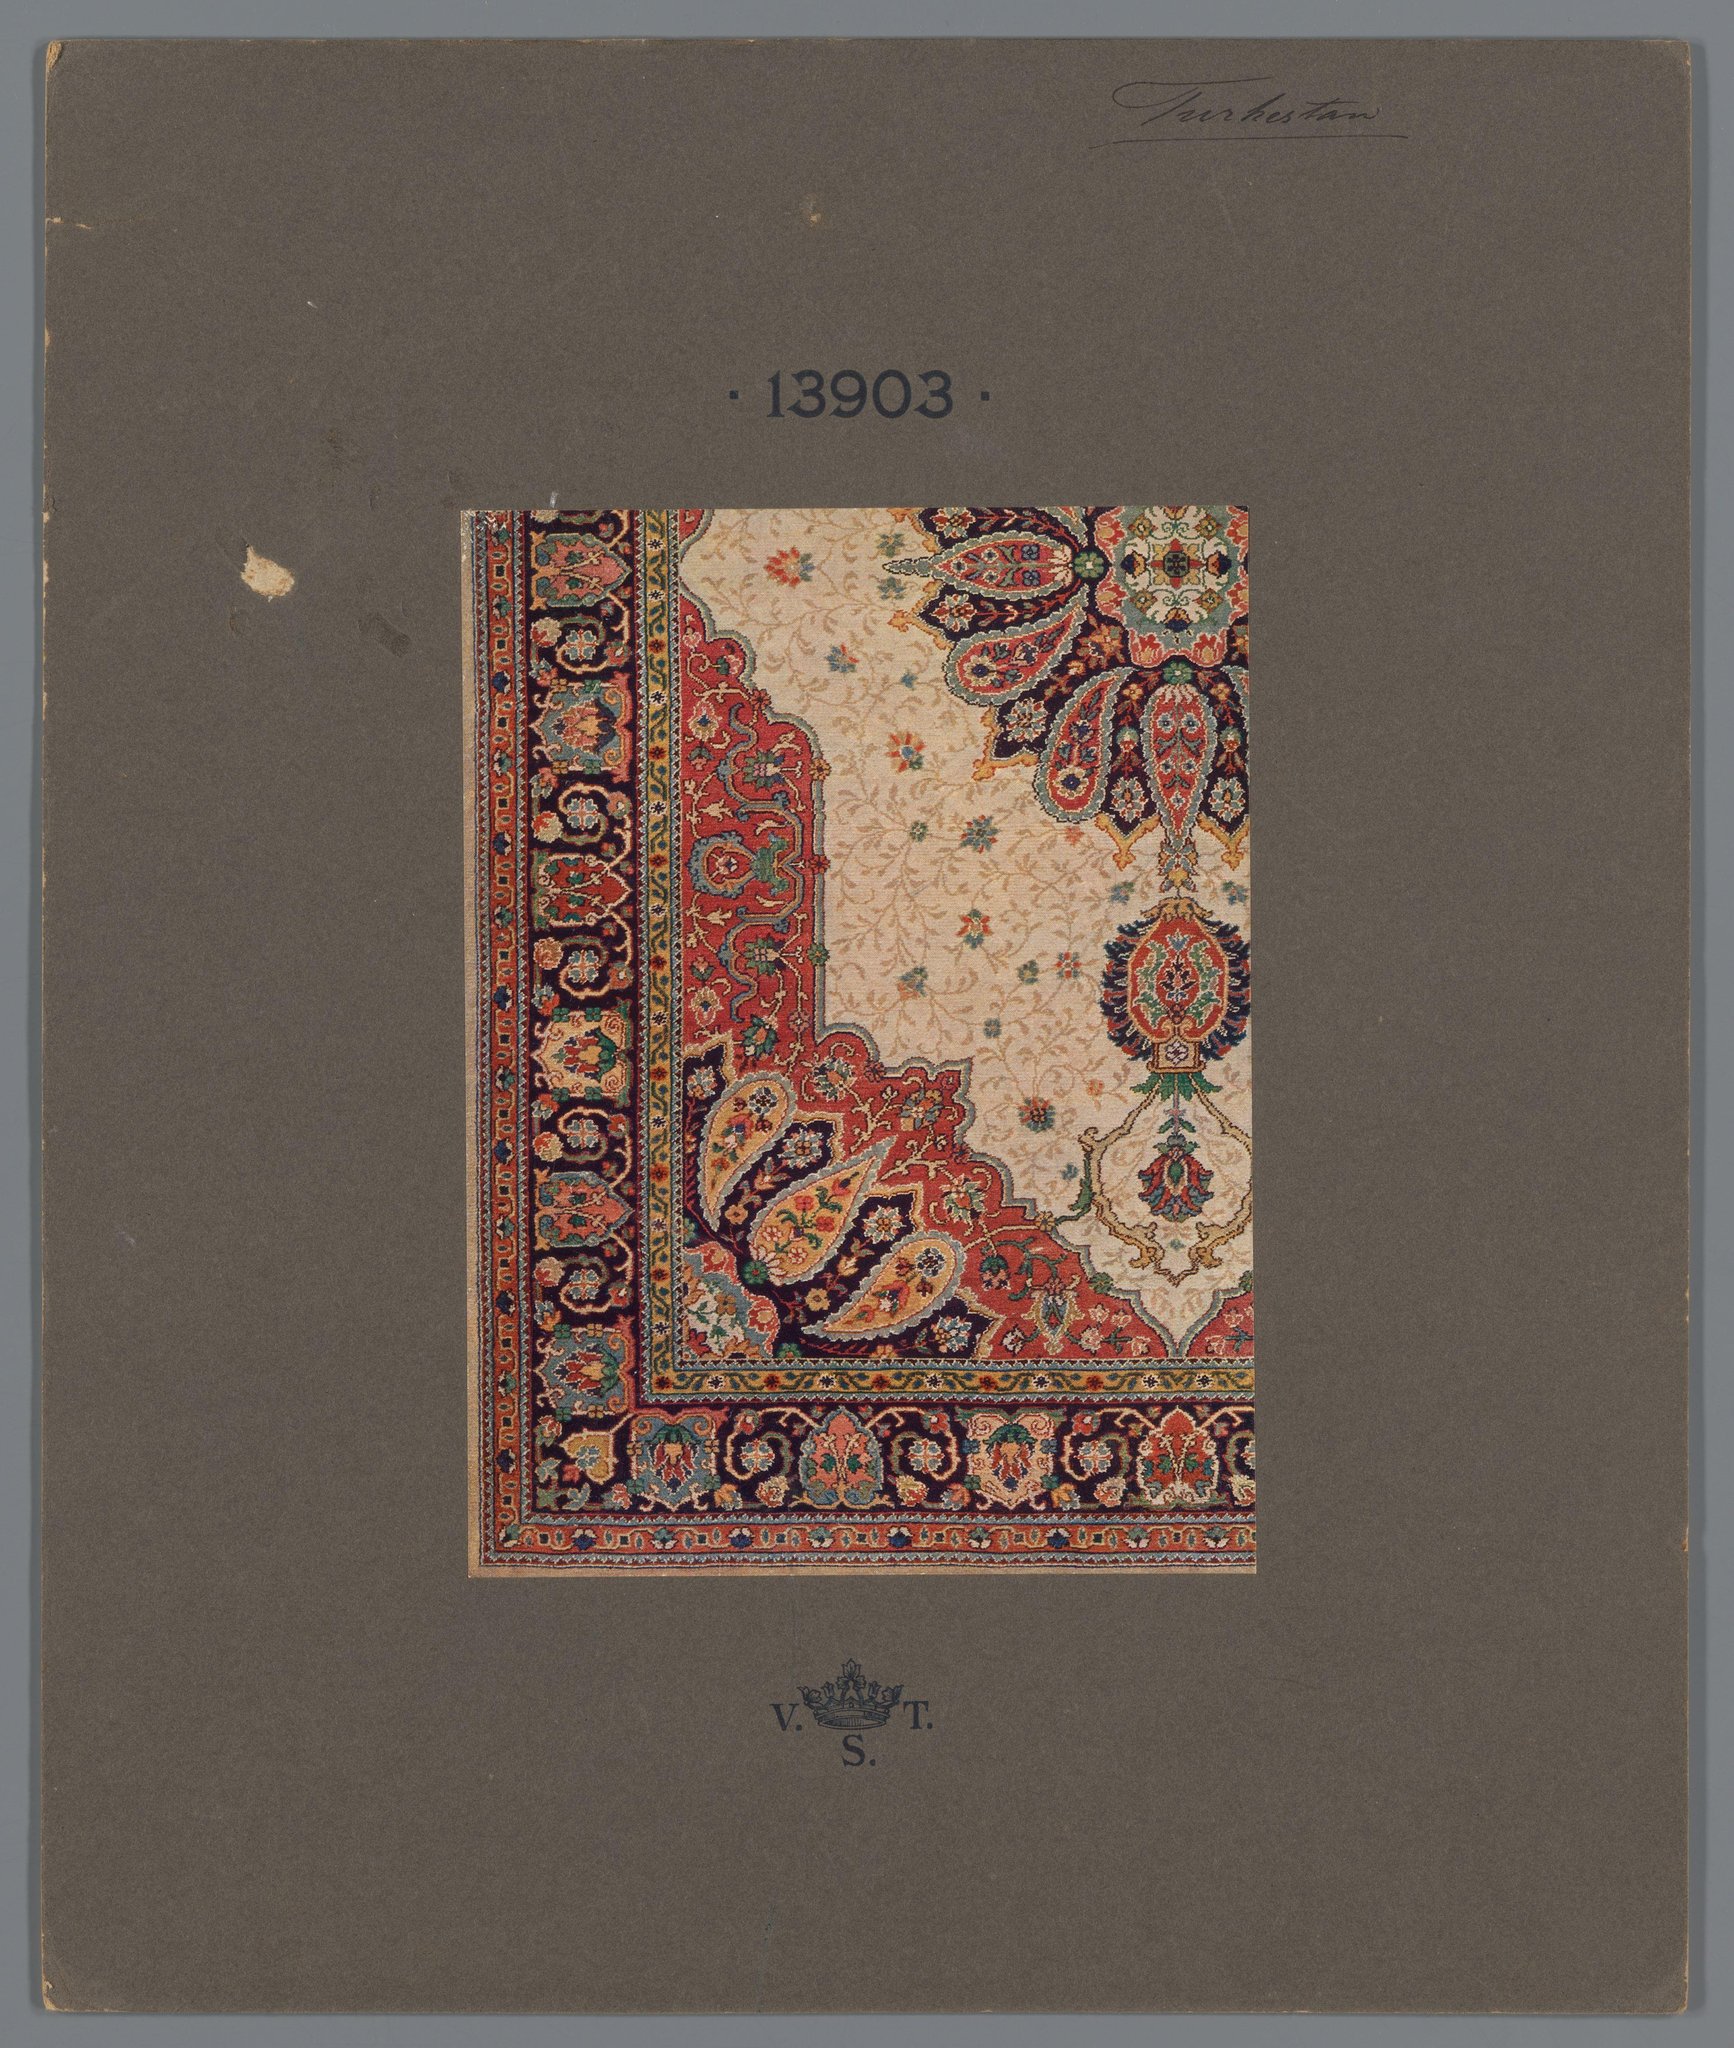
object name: photomechanical print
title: Deel van een tapijt met bloemenpatroon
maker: Anonymous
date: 1907-1929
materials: cardboard, paper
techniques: autotype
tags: carpet, rug, flowers ~ ornament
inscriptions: number: ‘.13903.’, annotation: ‘Turkestan’, mark: ‘V.T.S.’